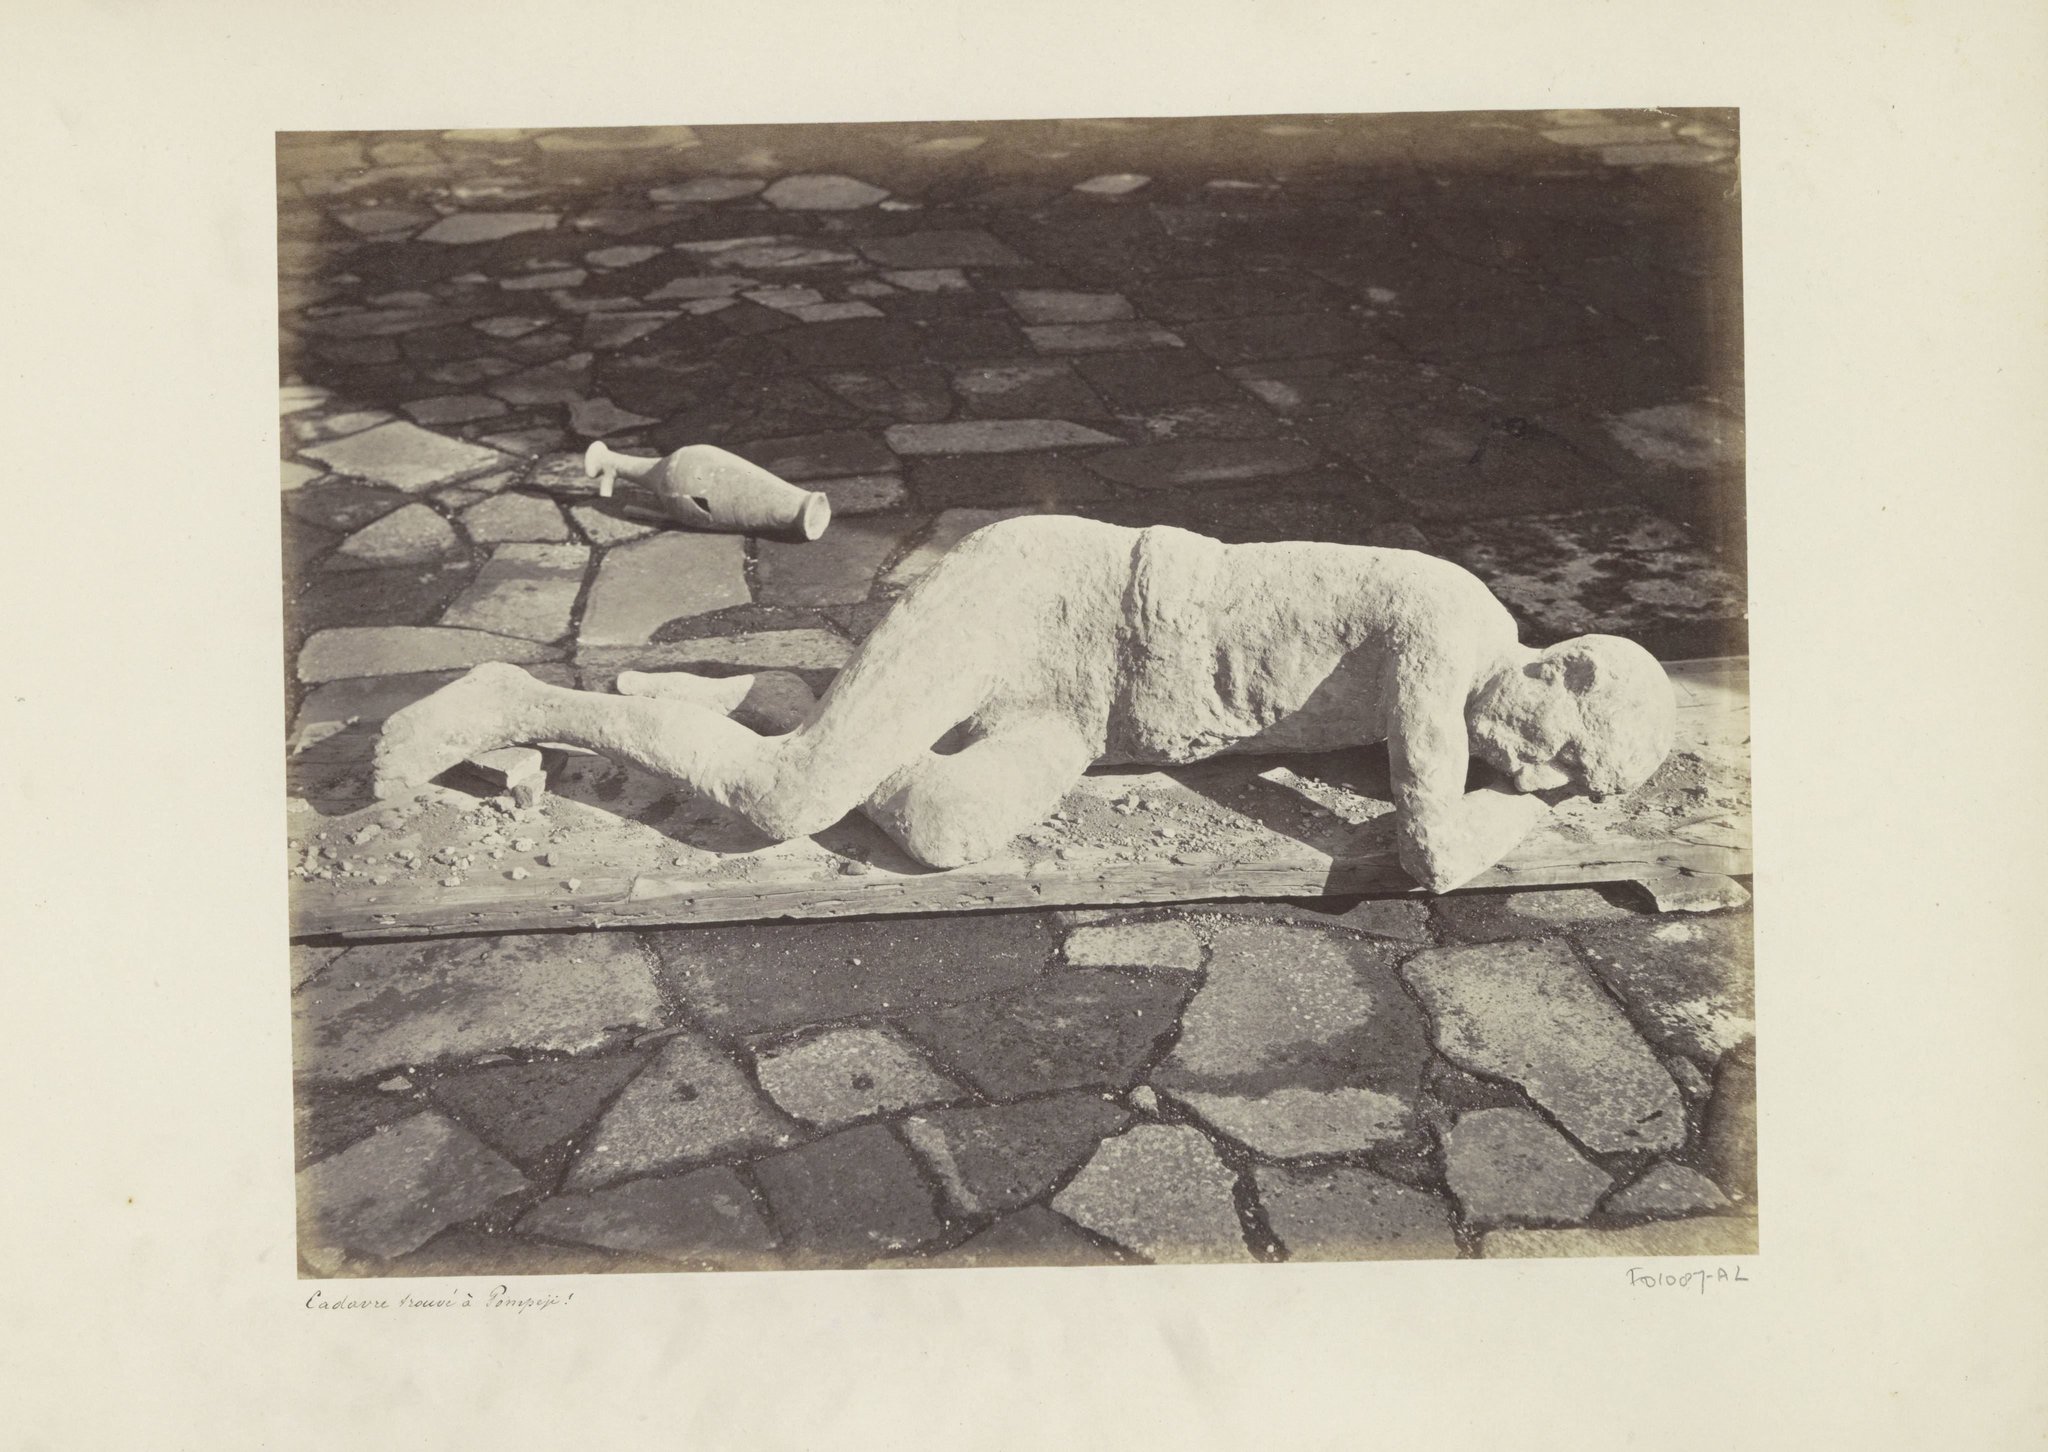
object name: photograph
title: Cadavre trouvé à Pompeji!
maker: Anonymous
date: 1865-1875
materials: paper, photographic support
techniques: albumen print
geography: pompeii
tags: adult man, pompeii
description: Onderdeel van Reisalbum met foto's van bezienswaardigheden in Napels en omgeving.